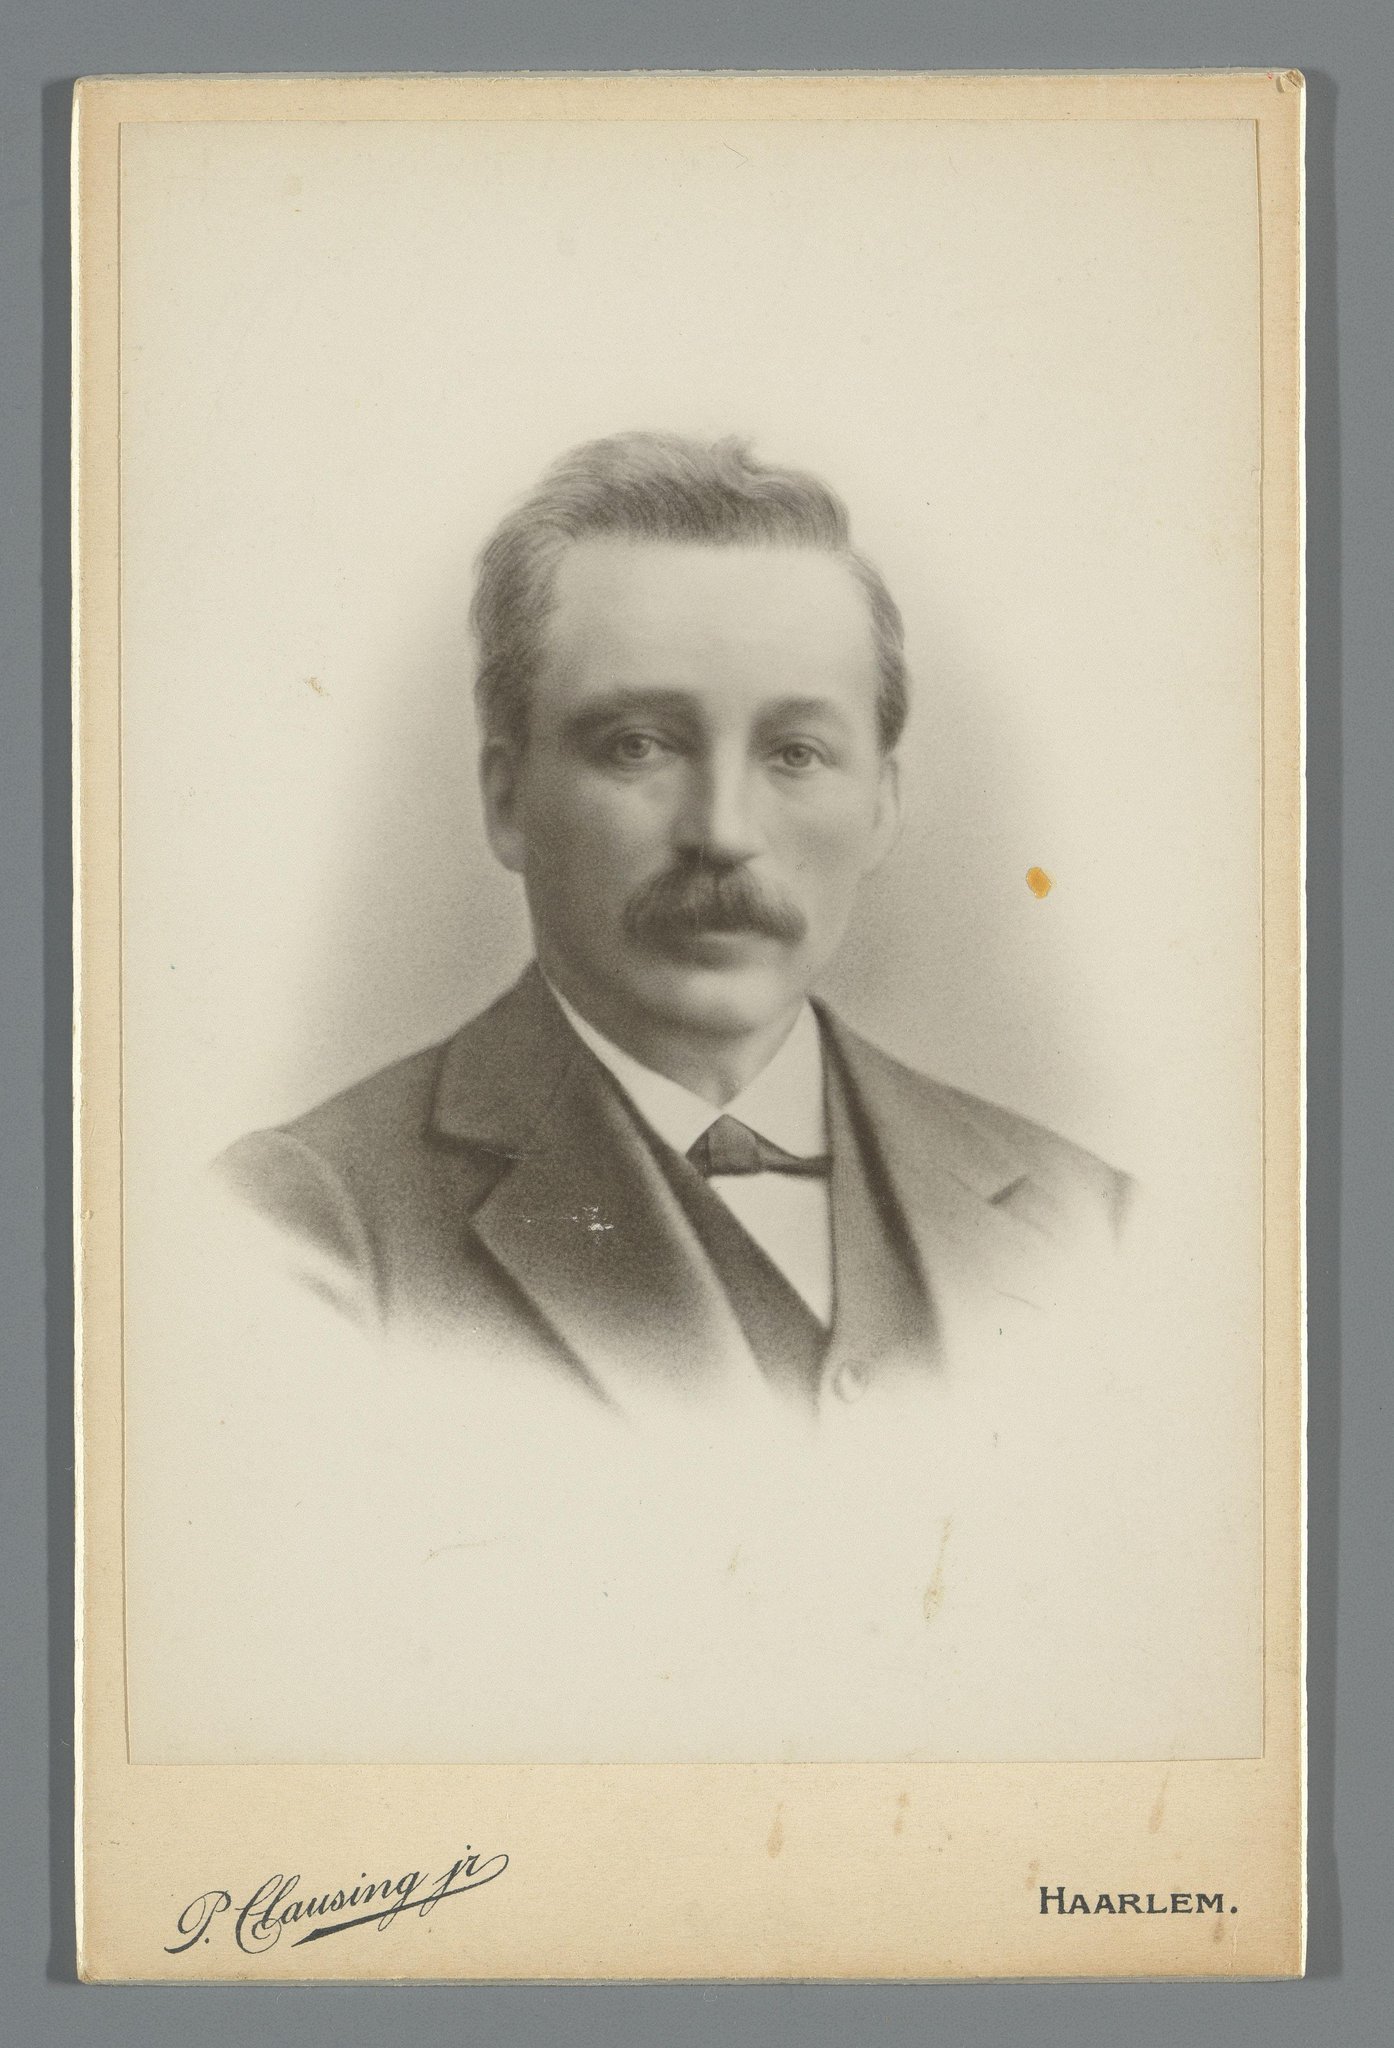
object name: photograph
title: Portret van Stephen Willem de Clercq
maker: peter clausing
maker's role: fotograaf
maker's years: 1870-1913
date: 1910-1913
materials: photographic support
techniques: photography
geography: haarlem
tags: historical persons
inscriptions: annotation: ‘S.W. de Clercq’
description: Portret van Stephen Willem de Clercq, zoon van Jkvr. Henriette de Clercq-Teding van Berkhout en Willem de Clercq.